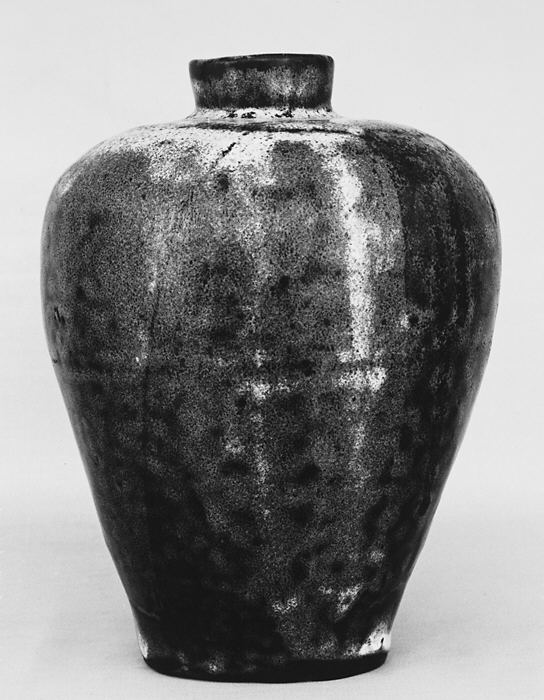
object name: jar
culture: japanese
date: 1801-1900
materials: clay, glaze